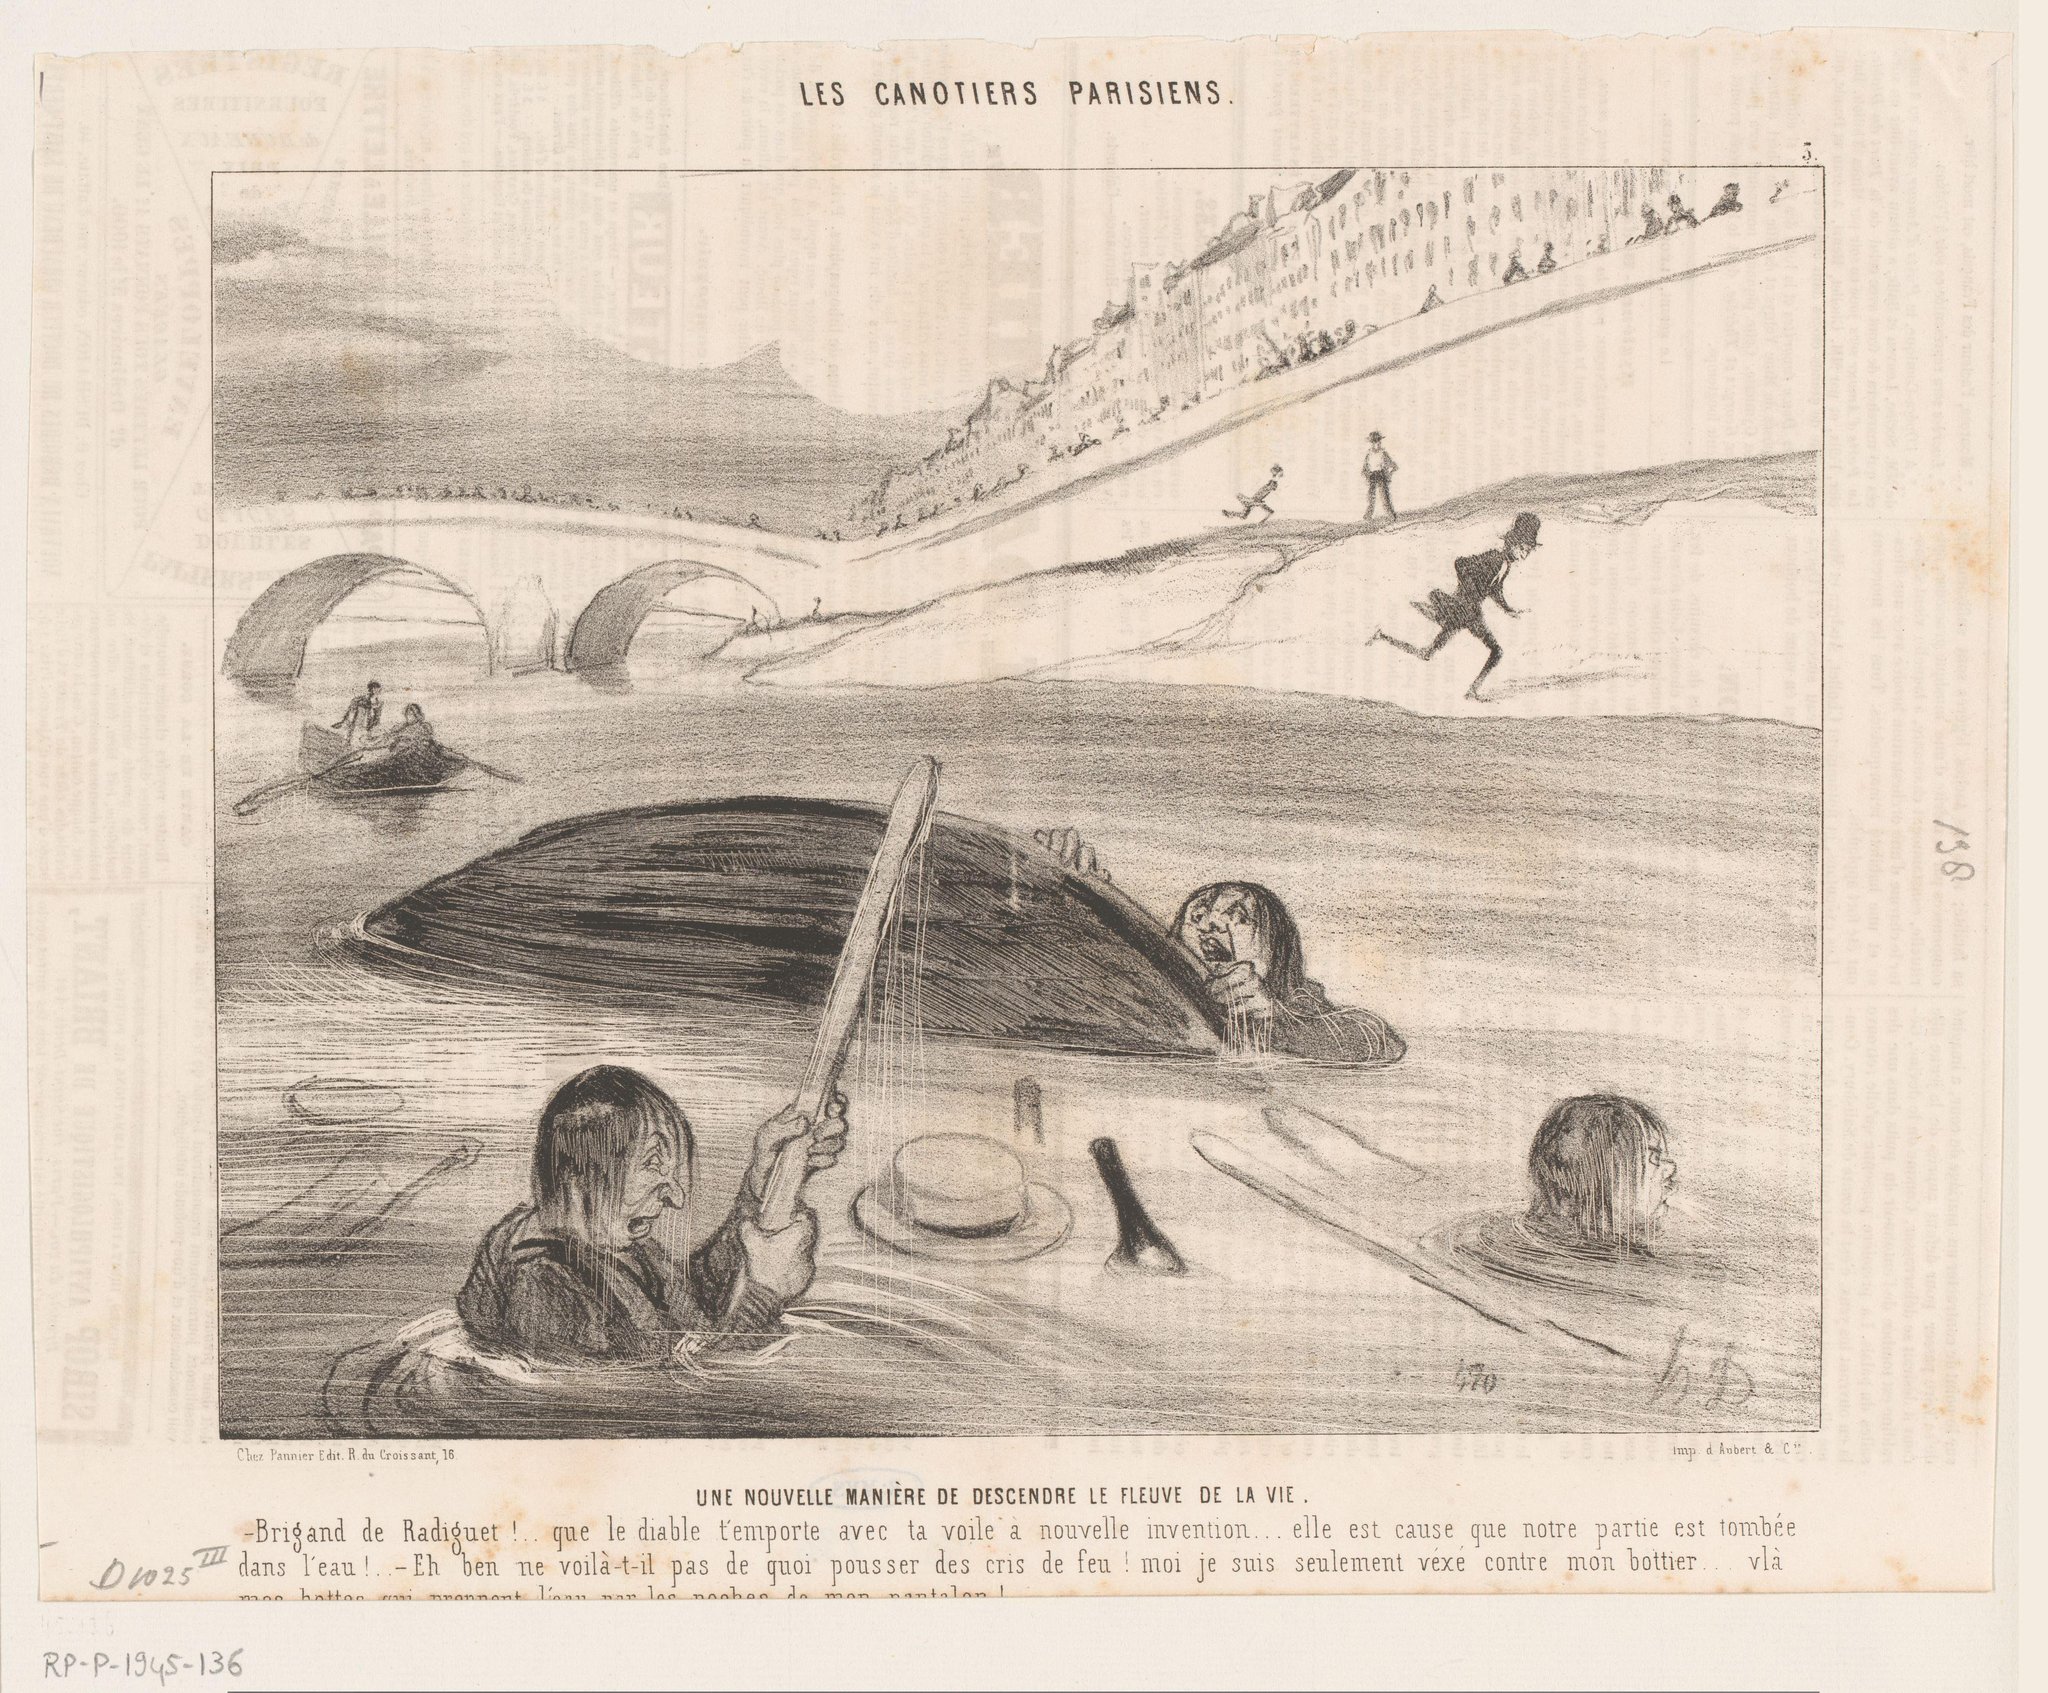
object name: cartoon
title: Parijse schippers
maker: honoré daumier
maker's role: draughtsman, painter, print maker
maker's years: 1808-1879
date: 1843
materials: paper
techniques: lithograph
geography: paris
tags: caricatures (human types), river, rowing-boat, canoe, etc. (+ accident, collision, crash ~ traffic and transport), falling overboard, paris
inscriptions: collector's mark: Lugt 2228a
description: Prent gepubliceerd in: Le Charivari, Aubert: Parijs, 22-04-1843. Le Charivari was een humoristische krant met karikaturen en (politieke) cartoons.